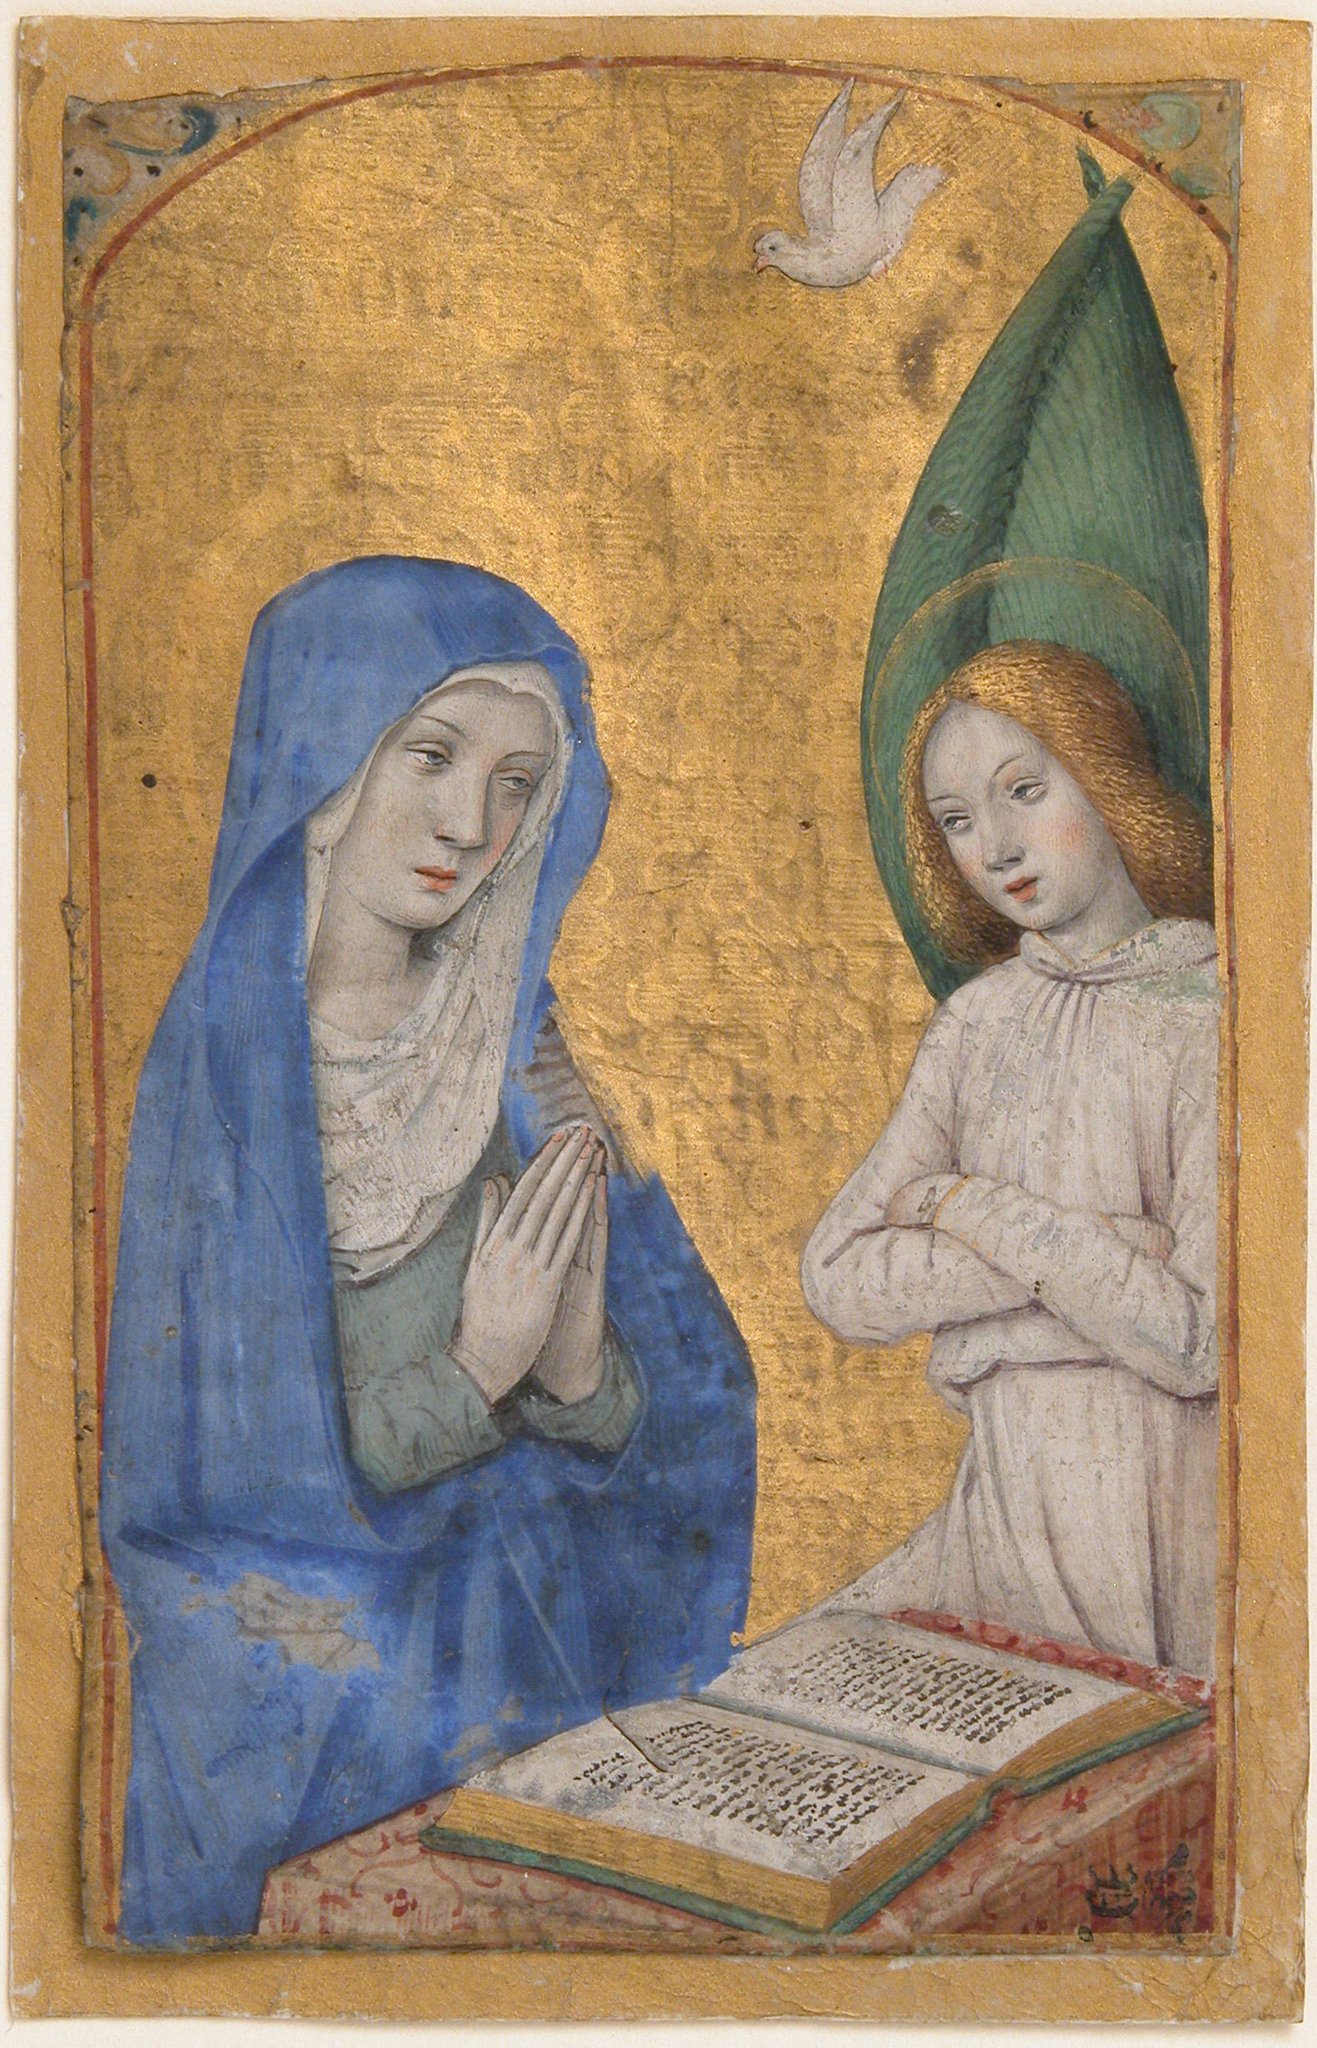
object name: book of hour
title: Manuscript Leaf with the Annunciation from a Book of Hours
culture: french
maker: jean bourdichon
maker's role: artist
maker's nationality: french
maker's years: 1457-1521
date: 1485-1490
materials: gold, parchment, shell, paint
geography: france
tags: doves,virgin mary,archangel gabriel,annunciation